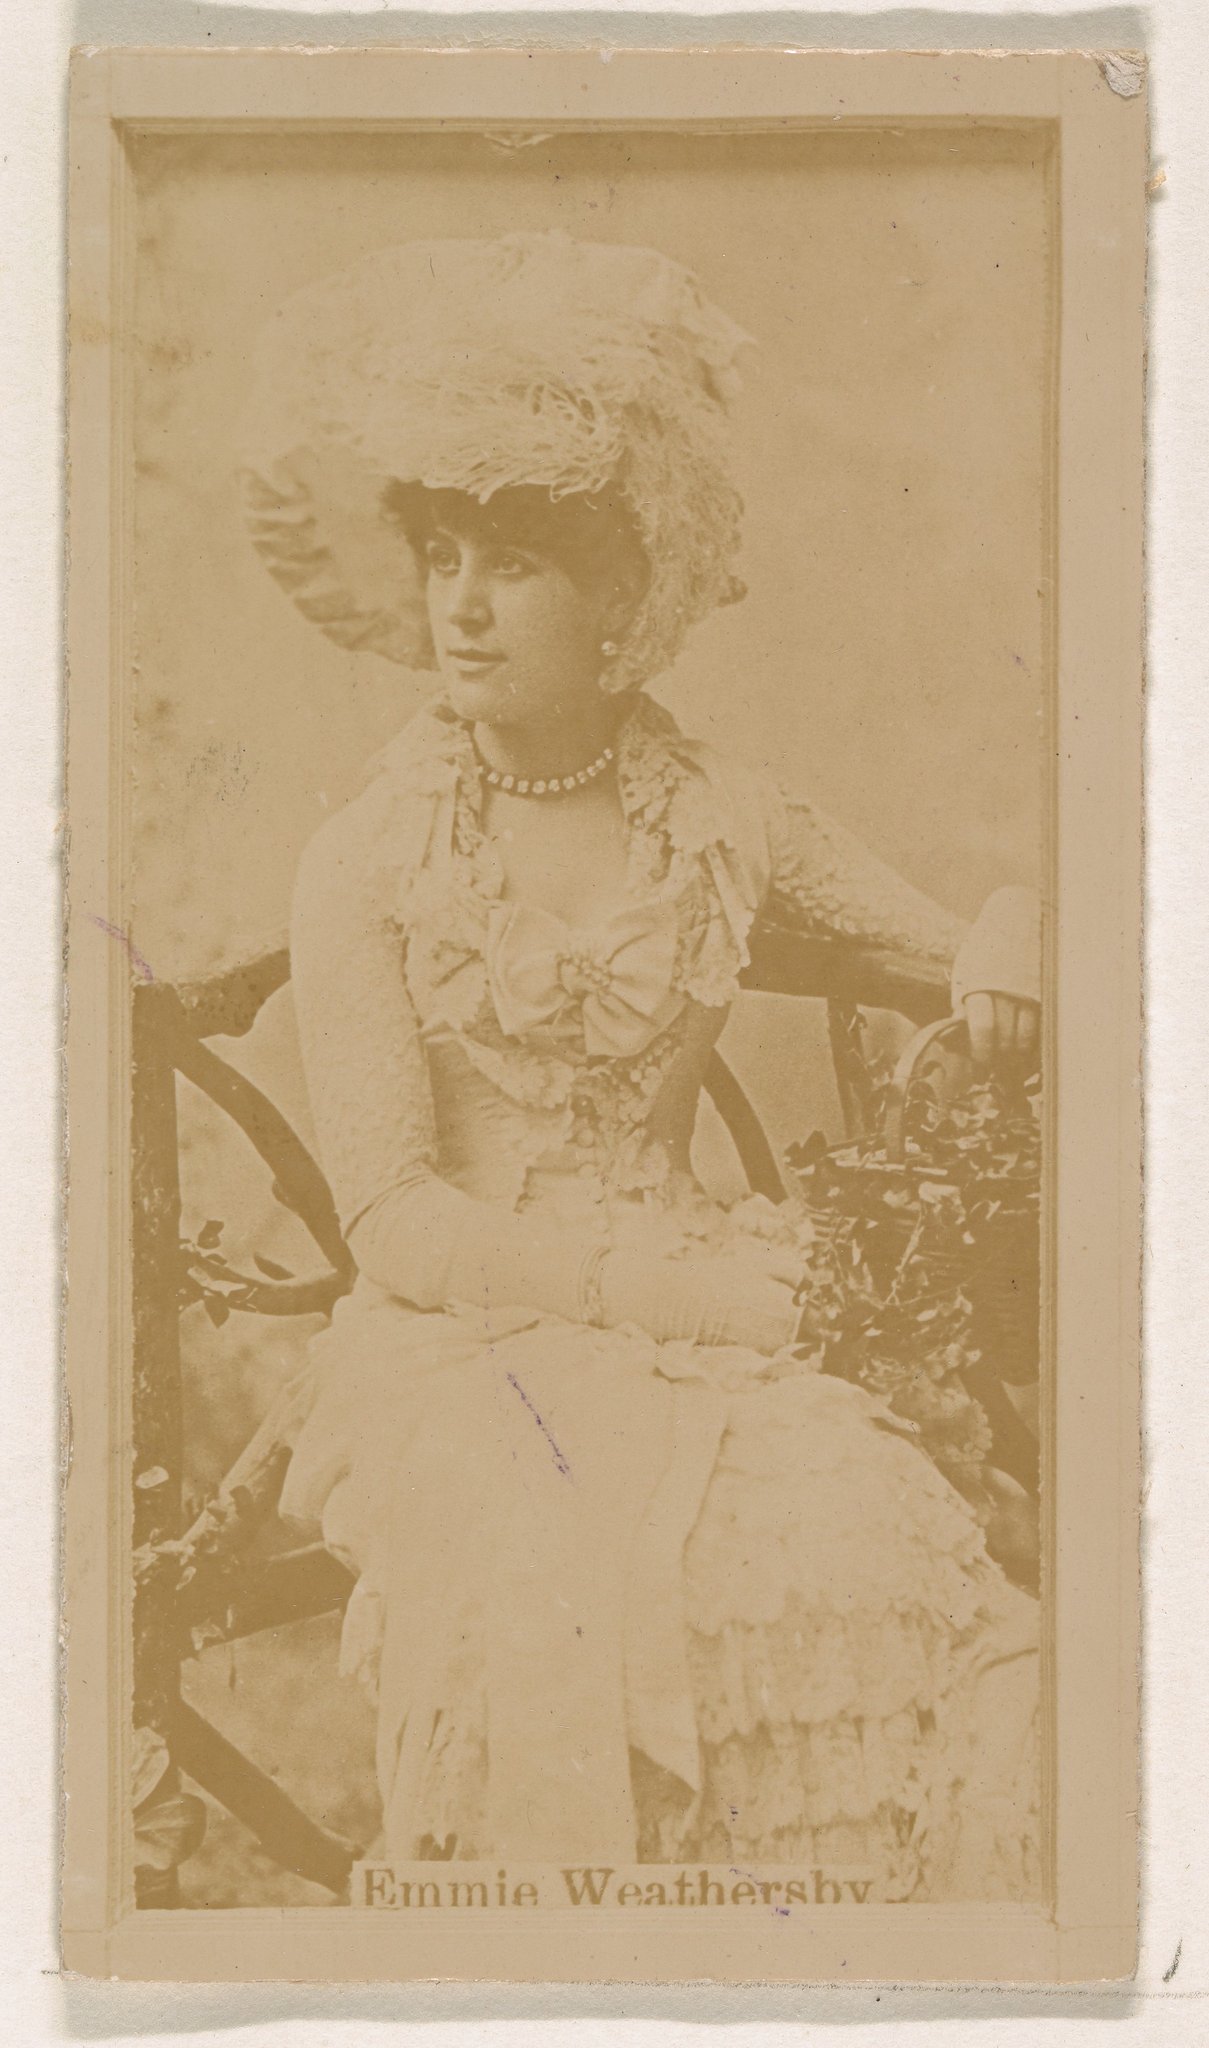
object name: photograph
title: Emmie Weathersby, from the Actresses series (N245) issued by Kinney Brothers to promote Sweet Caporal Cigarettes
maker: kinney brothers tobacco company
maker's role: publisher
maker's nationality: american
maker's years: 1869-2011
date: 1890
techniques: albumen silver print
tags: portraits,women,actresses